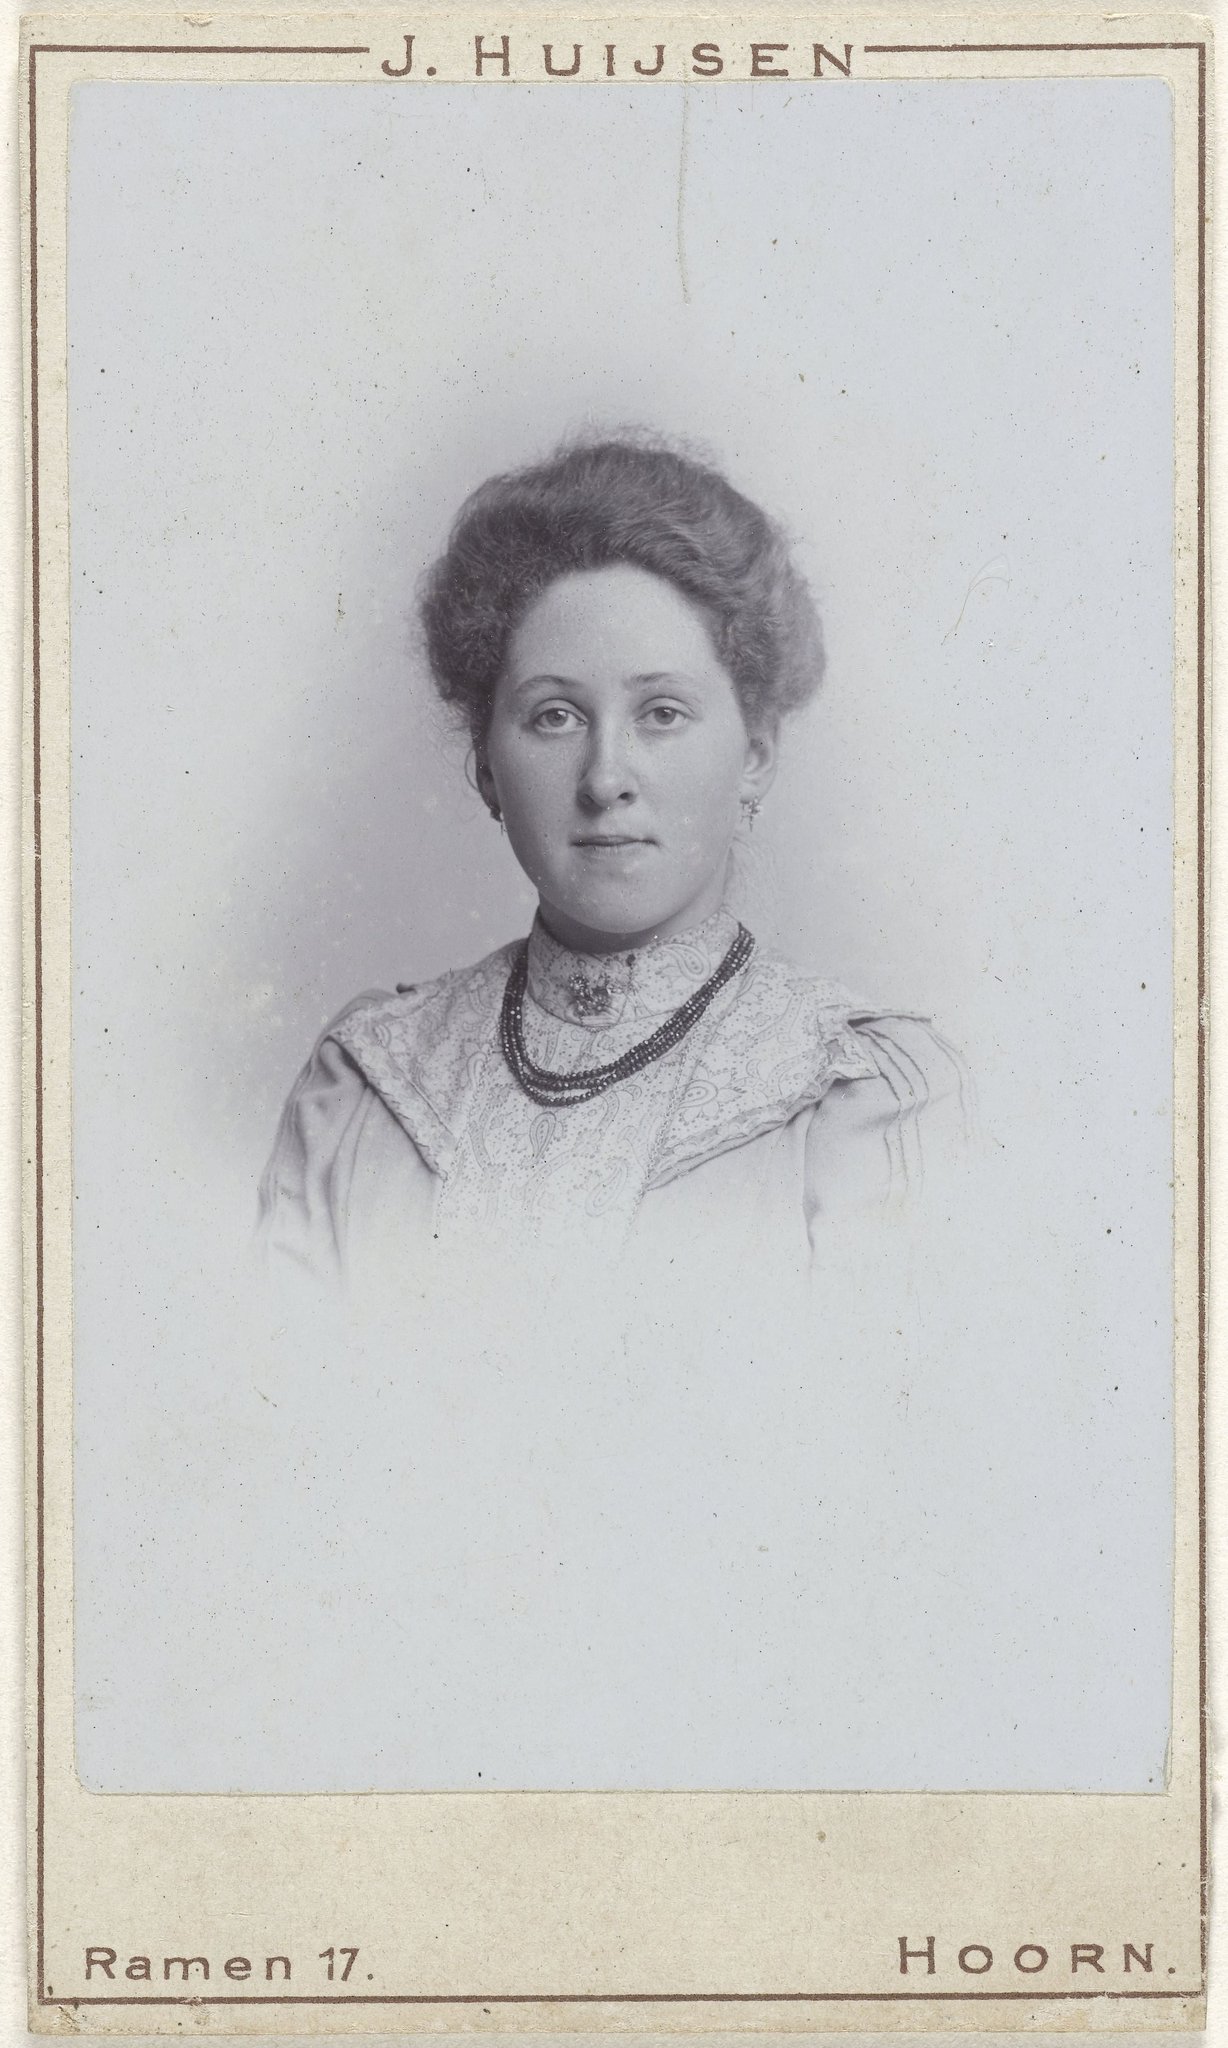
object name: carte de visite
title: Portret van Grietje Groot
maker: johannes laurens theodorus huijsen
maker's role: fotograaf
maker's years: 1852-1910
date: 1908-1915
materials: photographic support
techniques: albumen print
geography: hoorn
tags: chest, bust - aa - female human figure, hoorn (north holland)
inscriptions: name: ‘J.L.T. Huijsen Photographe Bekroond op verschillende tentoonstellingen Hoorn, Ramen 17’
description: Studioportret van een dame met collier, buste.